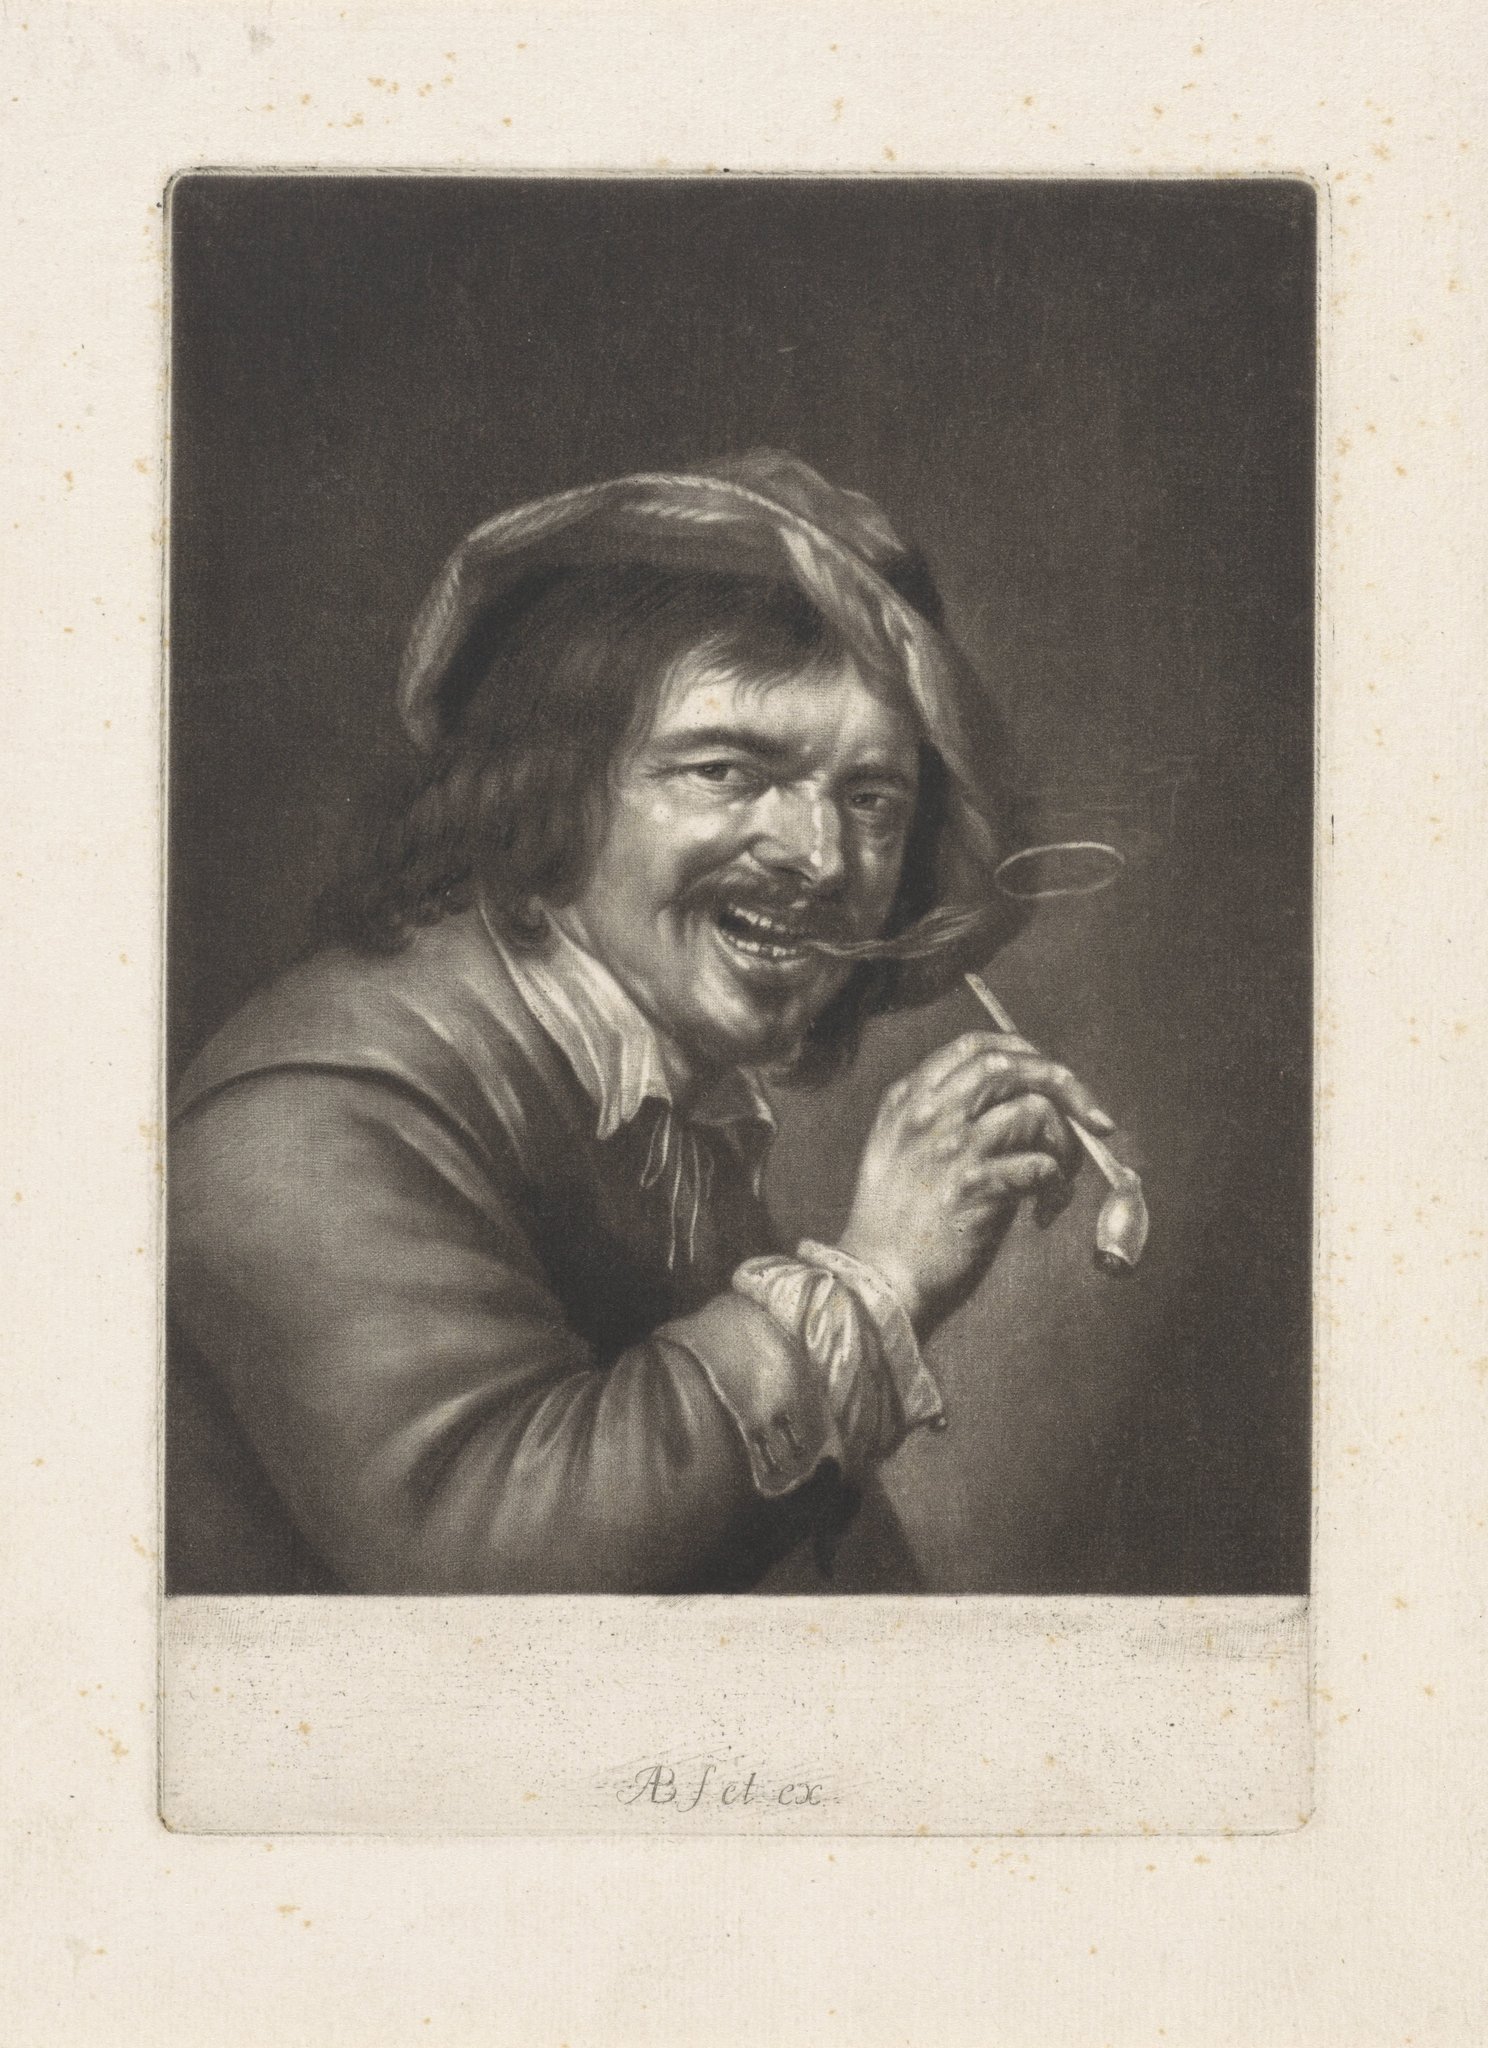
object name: print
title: Man met een pijp (de Reuk)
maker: abraham bloteling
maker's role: draughtsman, print maker, publisher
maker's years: 1640-1690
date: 1652-1690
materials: paper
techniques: mezzotint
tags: smell, smelling (one of the five senses), pipe ~ tobacco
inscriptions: collector's mark: Lugt 2760, collector's mark: Lugt 2166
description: Het zintuig Reuk. Een man rookt een pijp en blaast een ring van rook uit. De prent maakt deel uit van een serie met de vijf zintuigen.